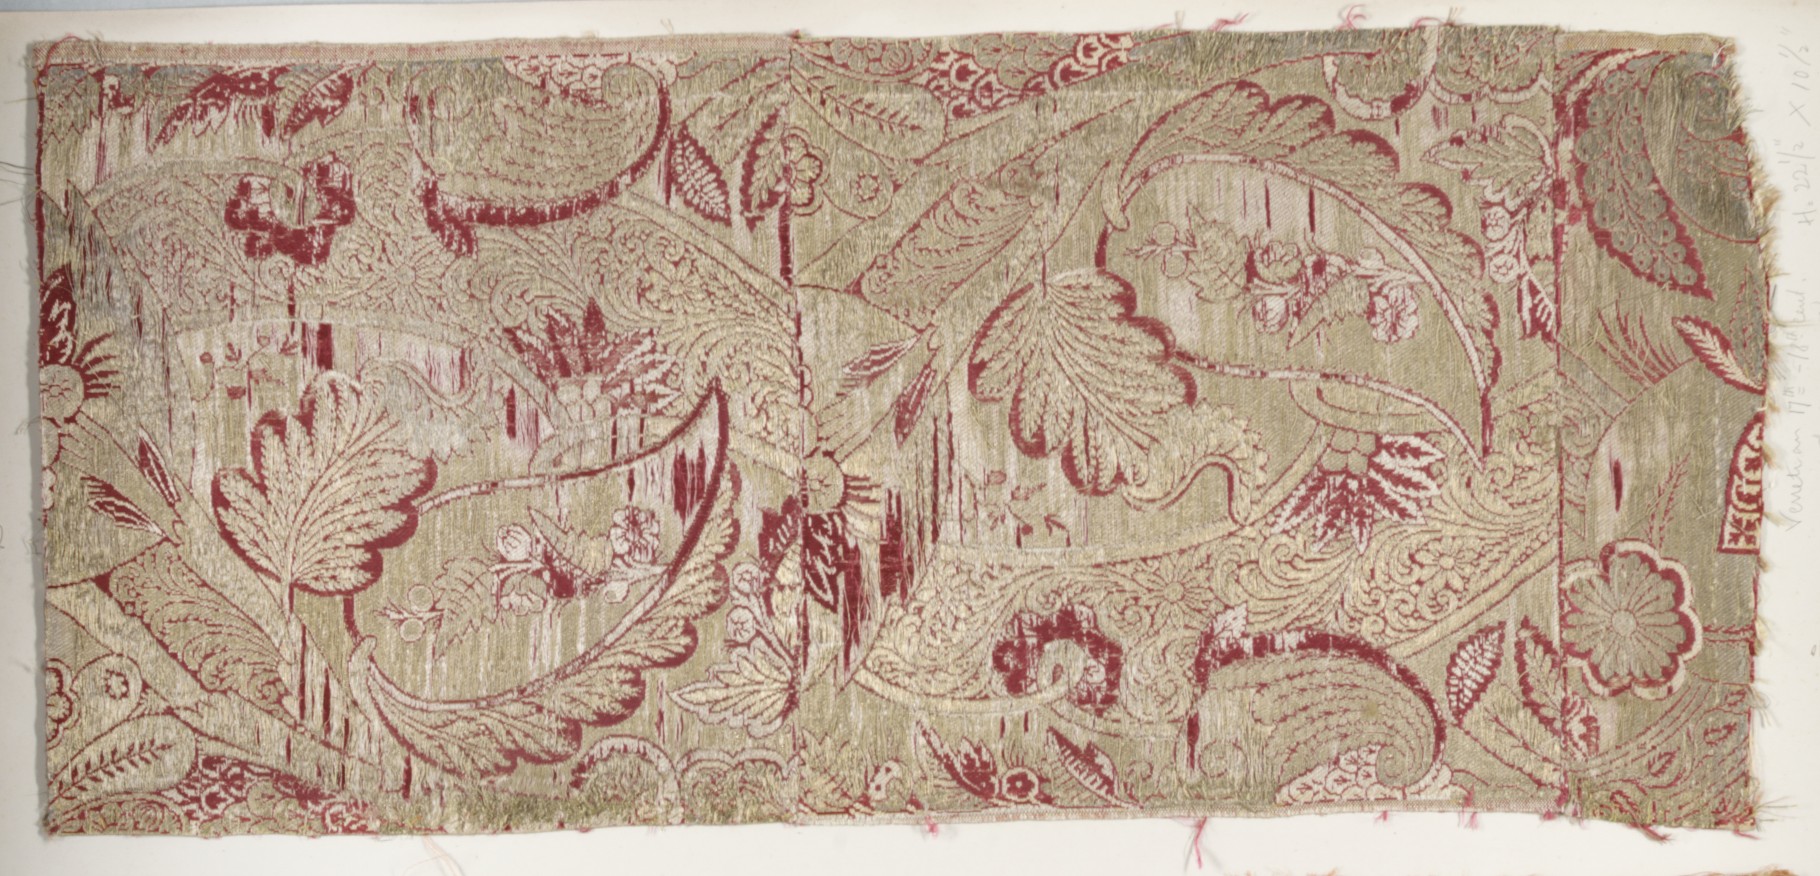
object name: fragment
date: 1701-1800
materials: metal thread, silk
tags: leaves